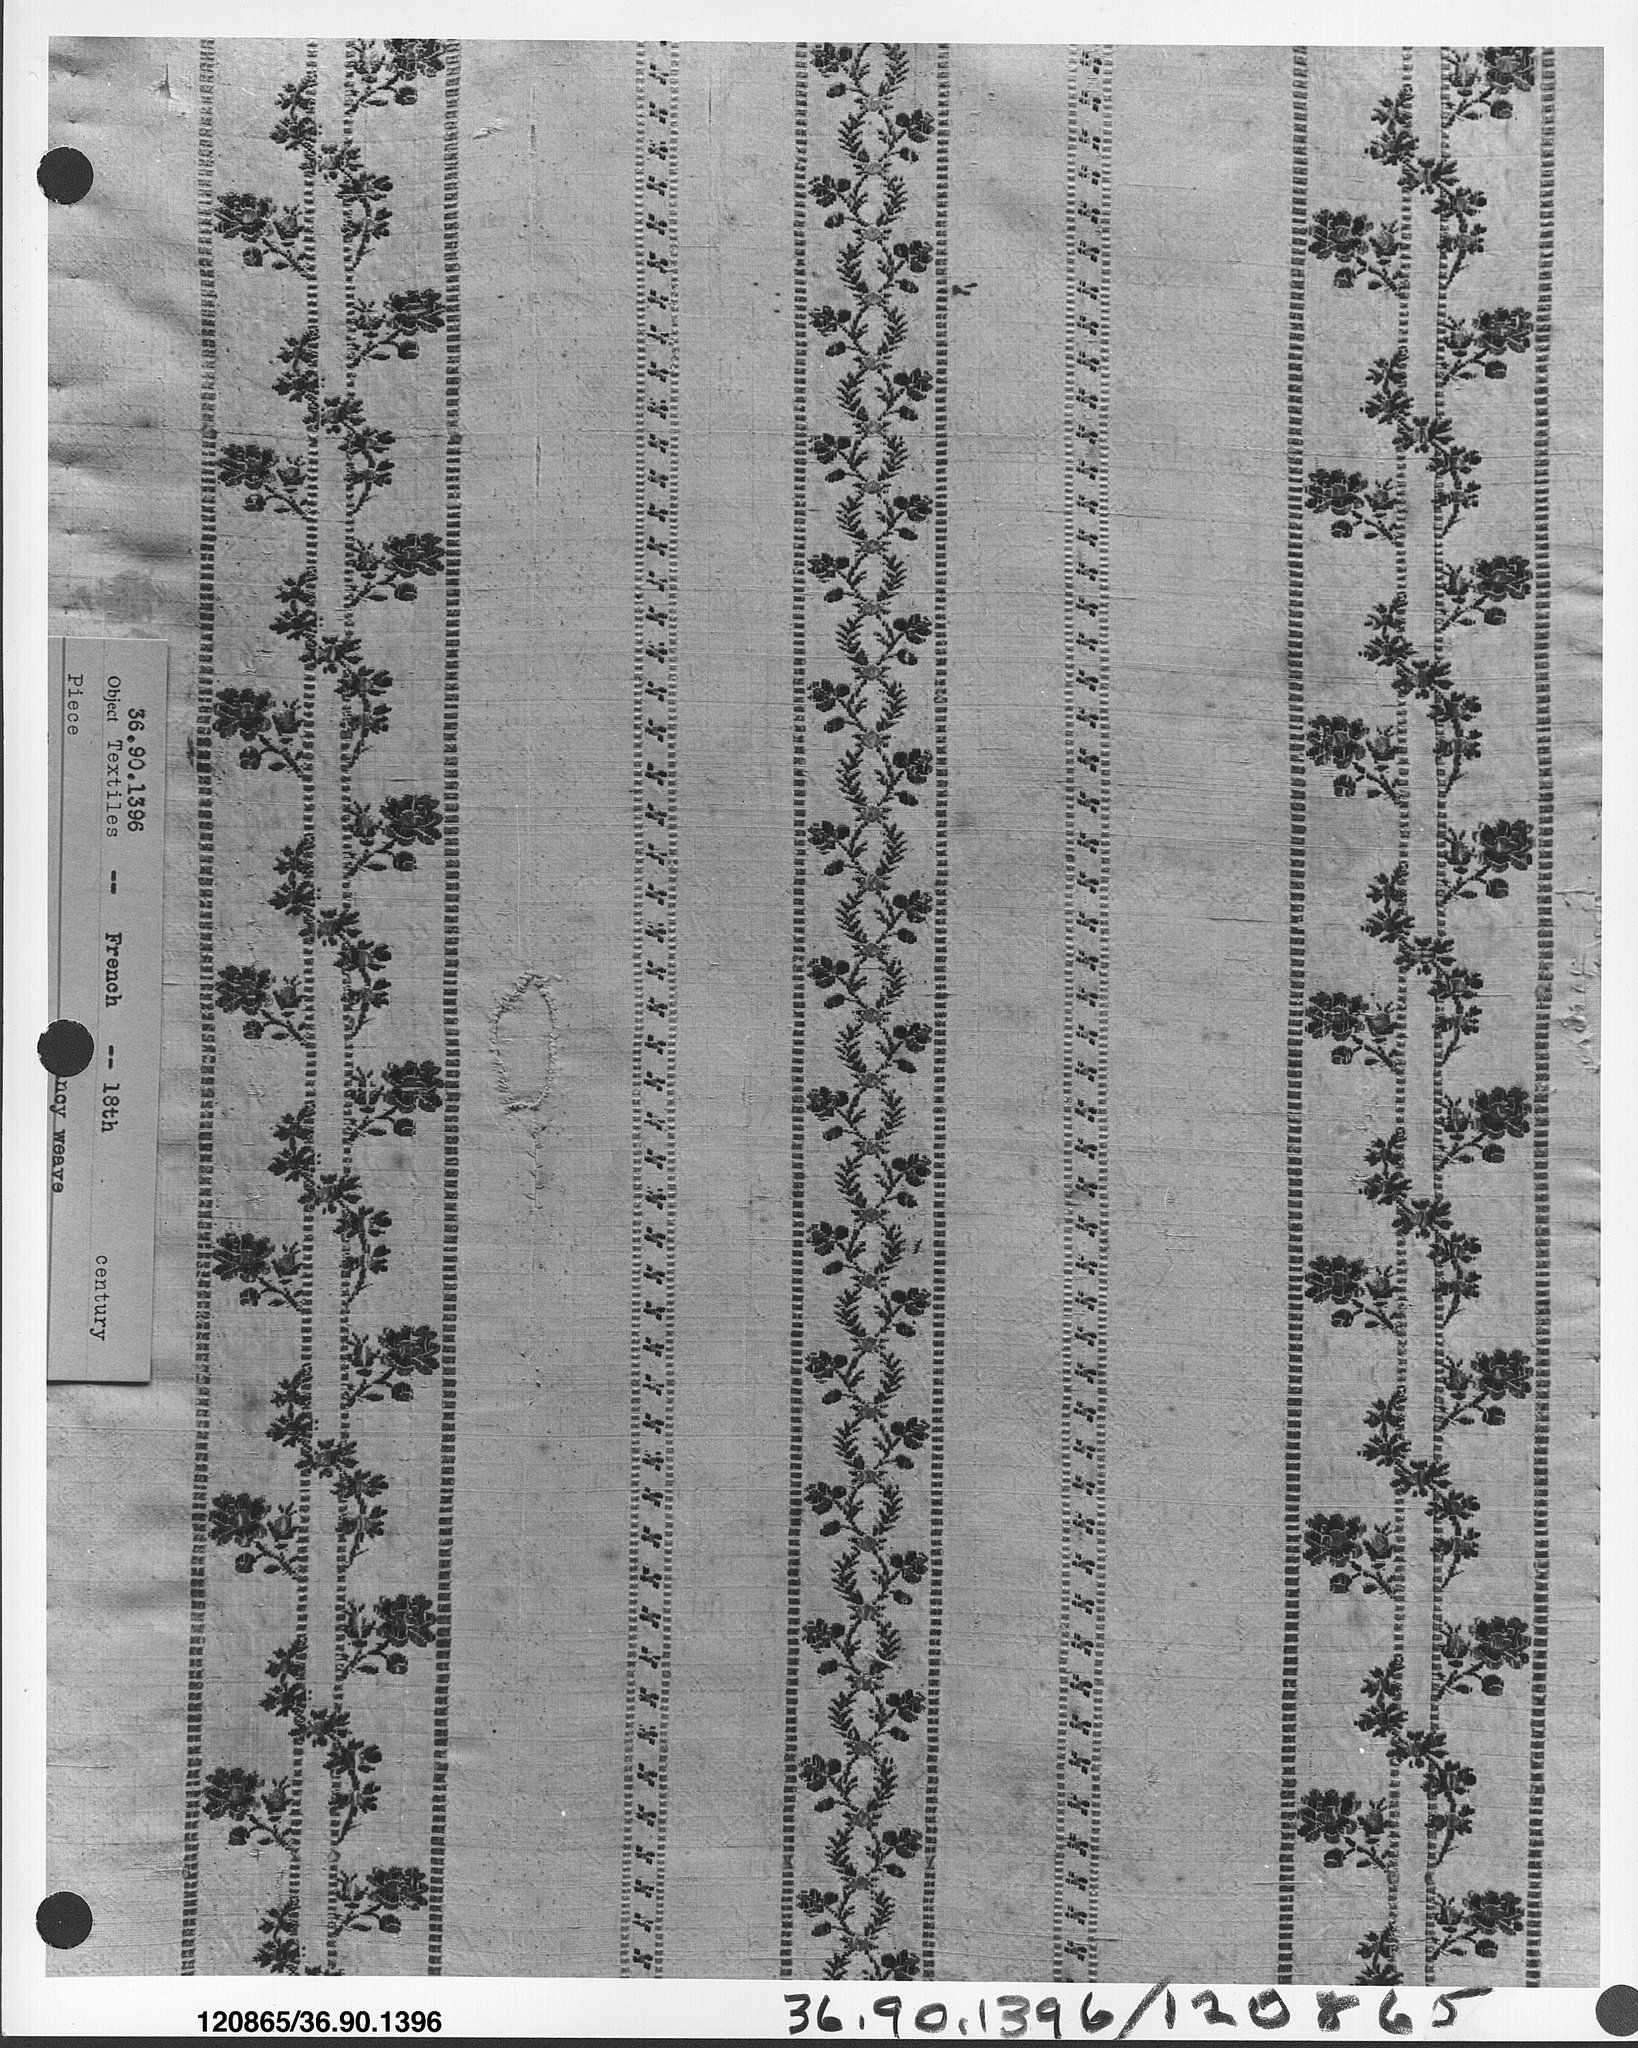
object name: piece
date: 1701-1800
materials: silk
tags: flowers,leaves